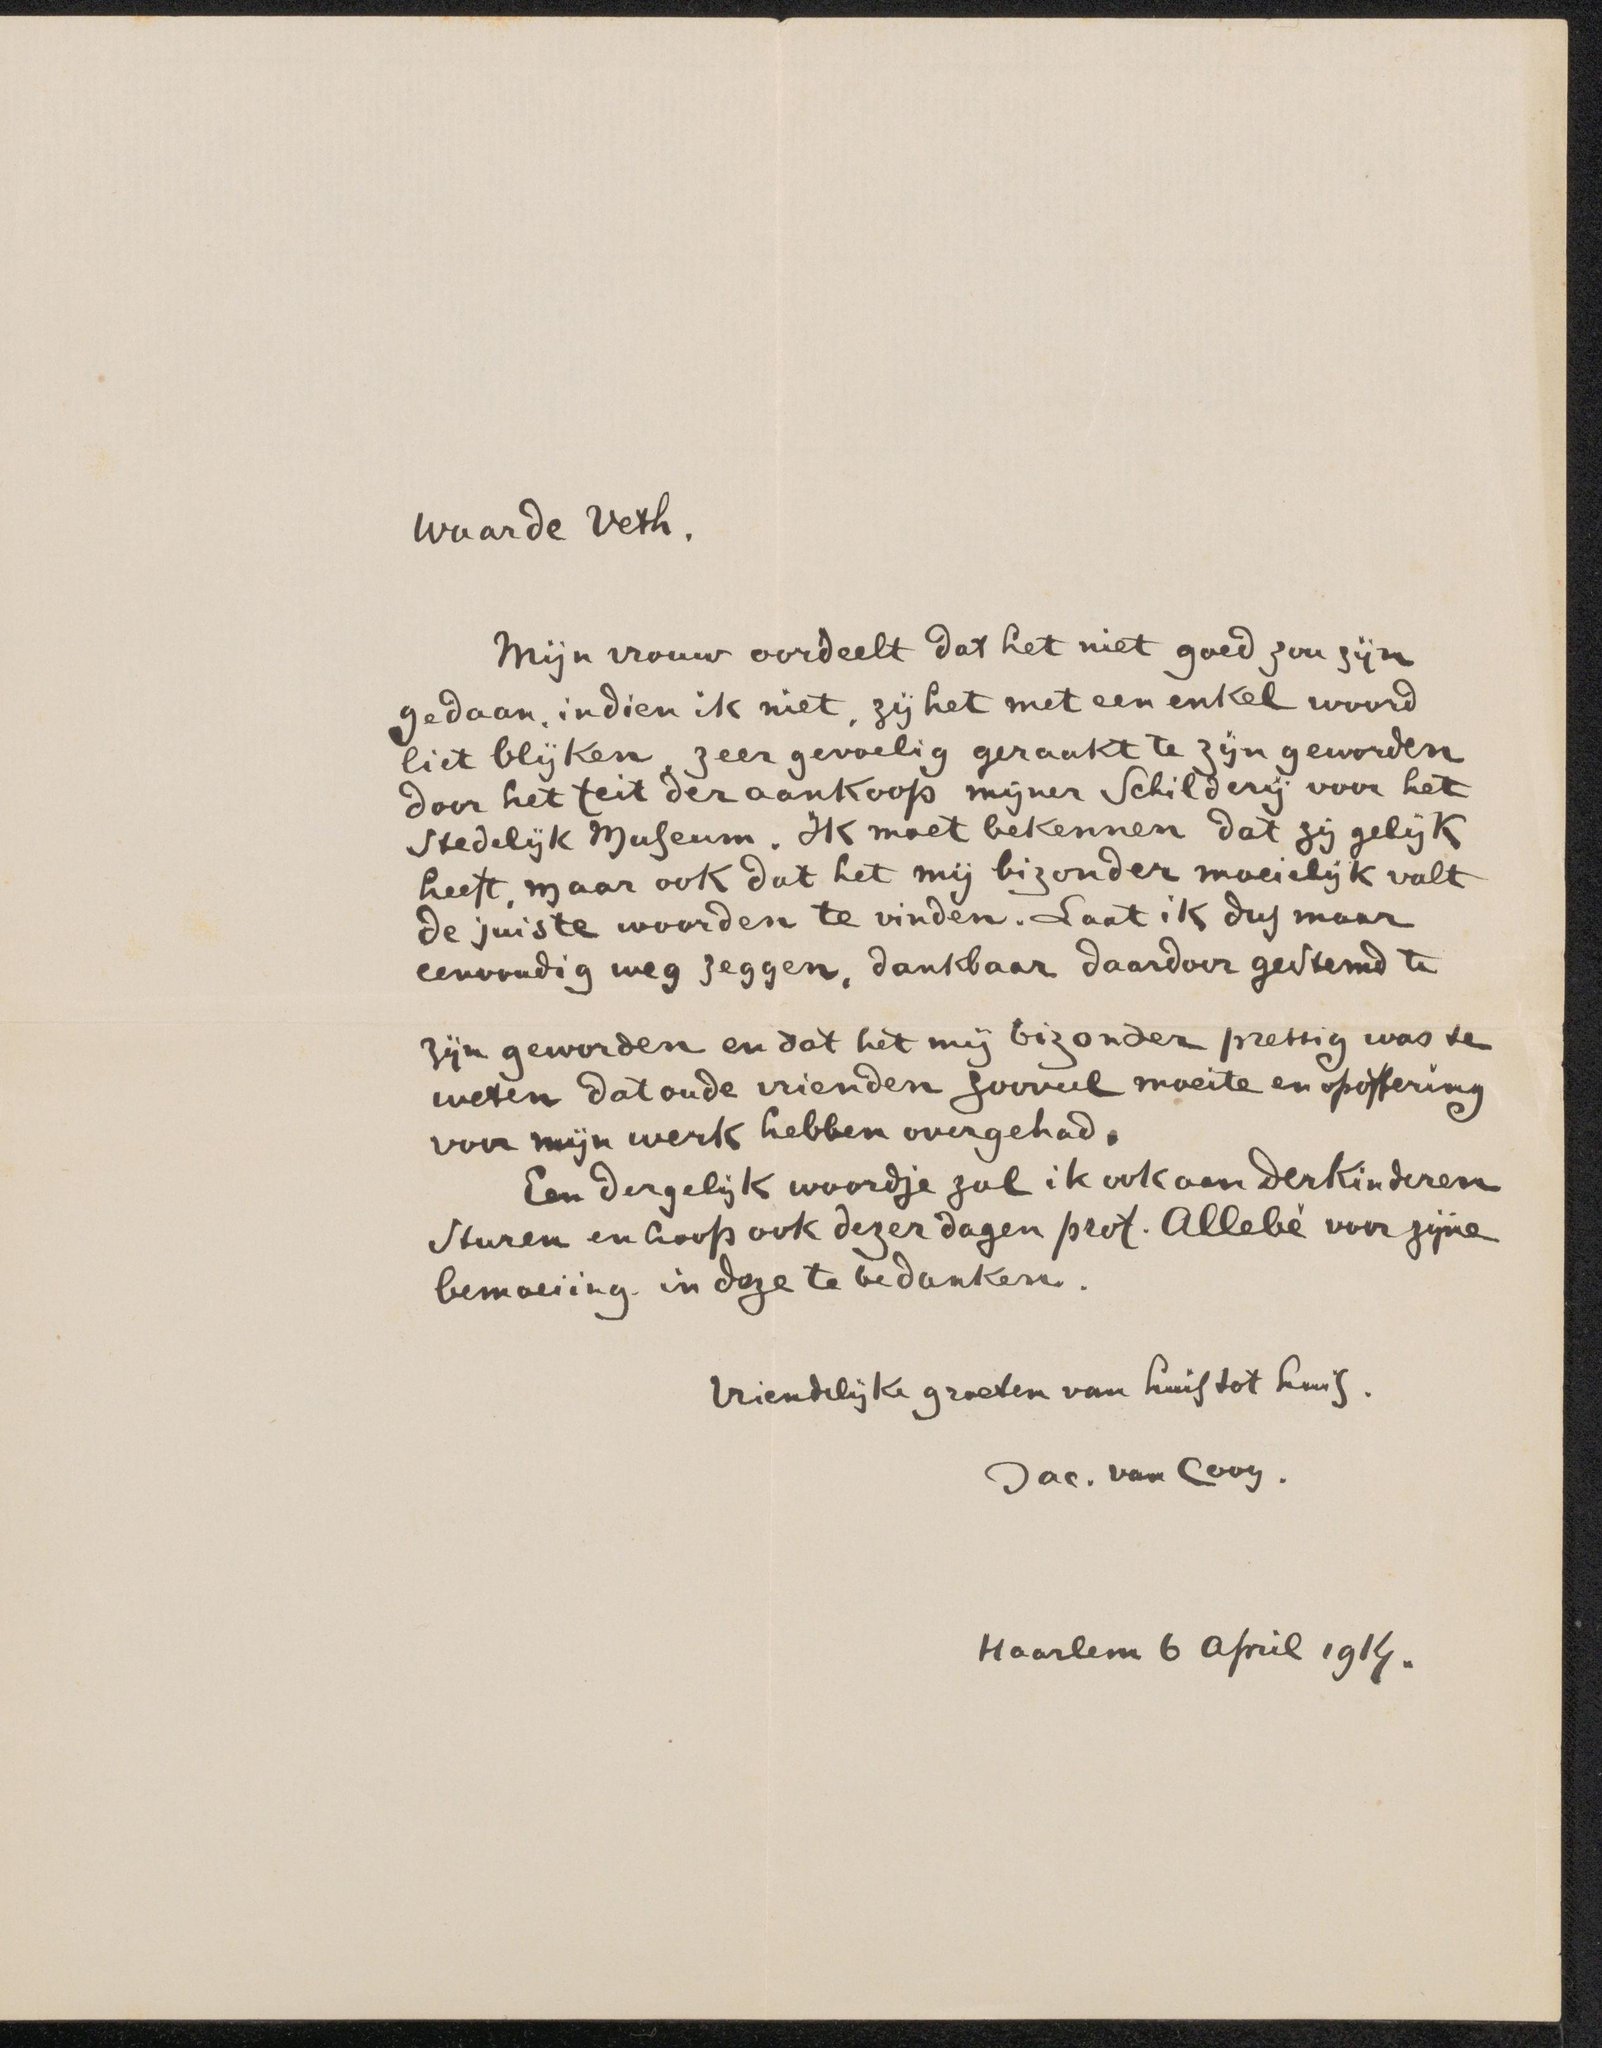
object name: letter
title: Brief aan Jan Veth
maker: jac van looij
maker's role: draughtsman, painter, print maker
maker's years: 1855-1930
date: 1914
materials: ink, paper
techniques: pen, writing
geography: haarlem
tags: august allebé, dordrecht, amsterdam, designer, jan veth, den bosch, antoon derkinderen, museum, painting (including book-illumination, miniature-painting), art collecting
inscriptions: collector's mark: ‘RPK’